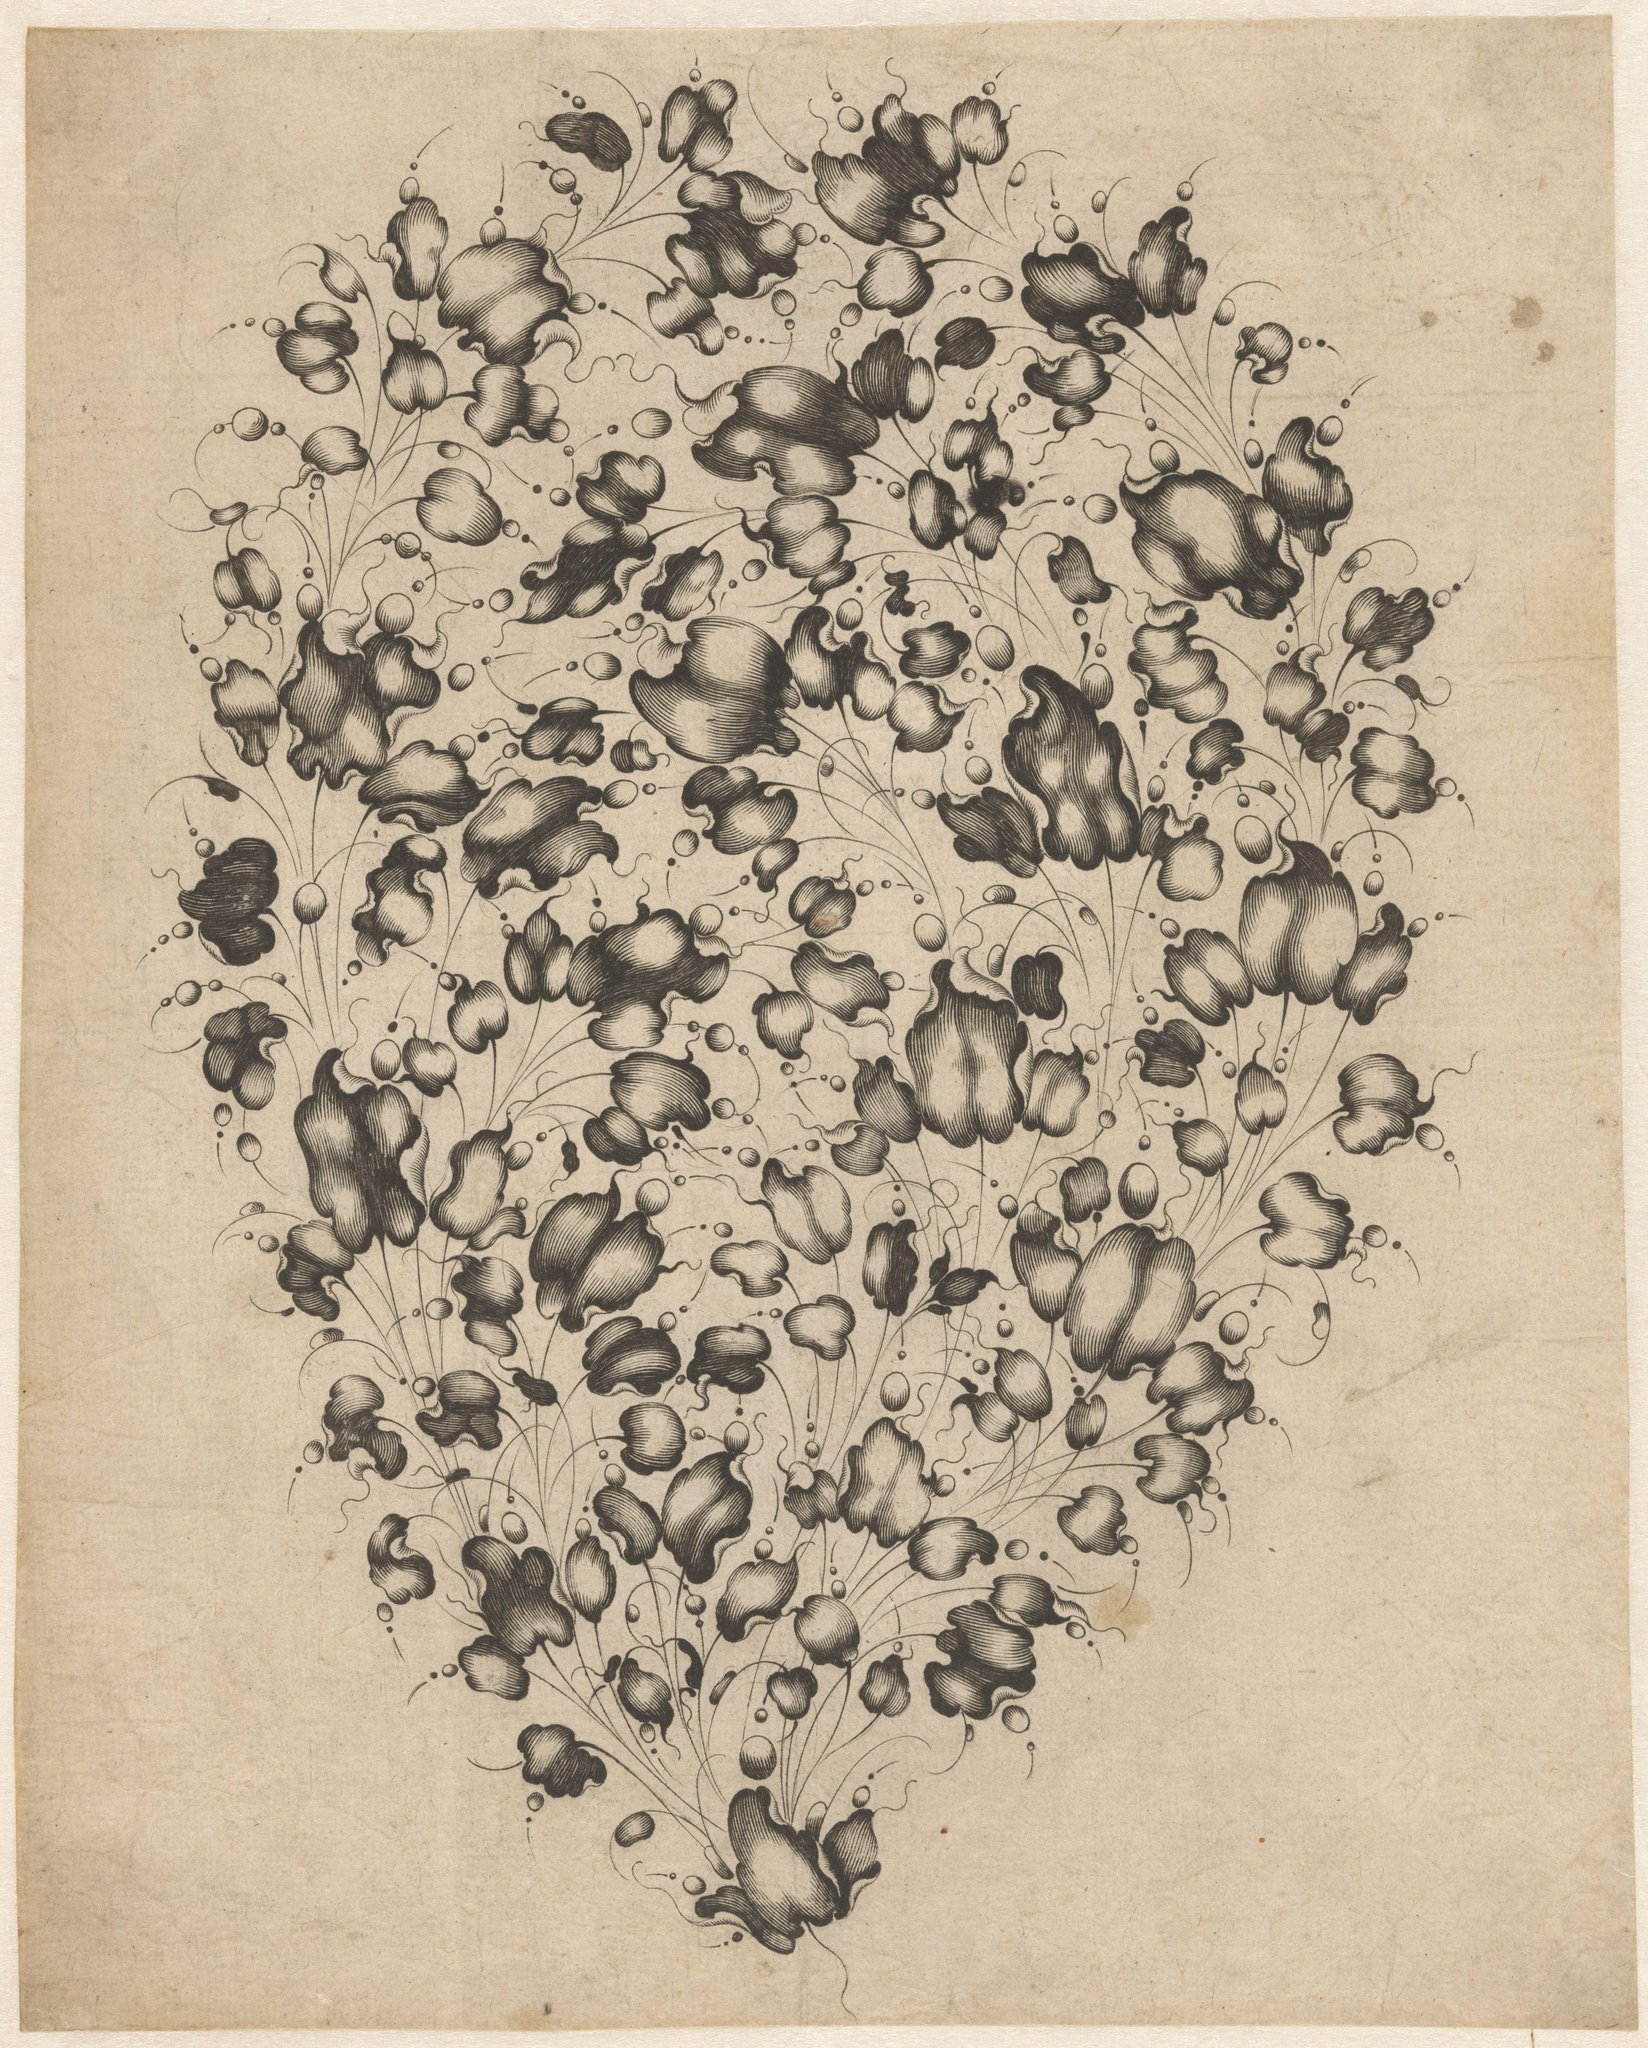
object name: ornament print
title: Cosses de pois Ornament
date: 1634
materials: paper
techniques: engraving, etching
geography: paris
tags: ornaments ~ art, foliage ~ ornament, scrollwork, strapwork ~ ornament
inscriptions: collector's mark: Lugt 2228, collector's mark: Lugt 2760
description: The Rijksmuseum recently acquired 150 prints collected by M.H. and L.B. (Wiet) Gans, renowned connoisseurs of antique silverware. Because of their rarity and virtuoso execution, these works represent a key addition to the collection of ornament prints. This certainly applies to the sheets in the so-called cosses de pois (peapod) style, such as this stylized, almost abstract bouquet.